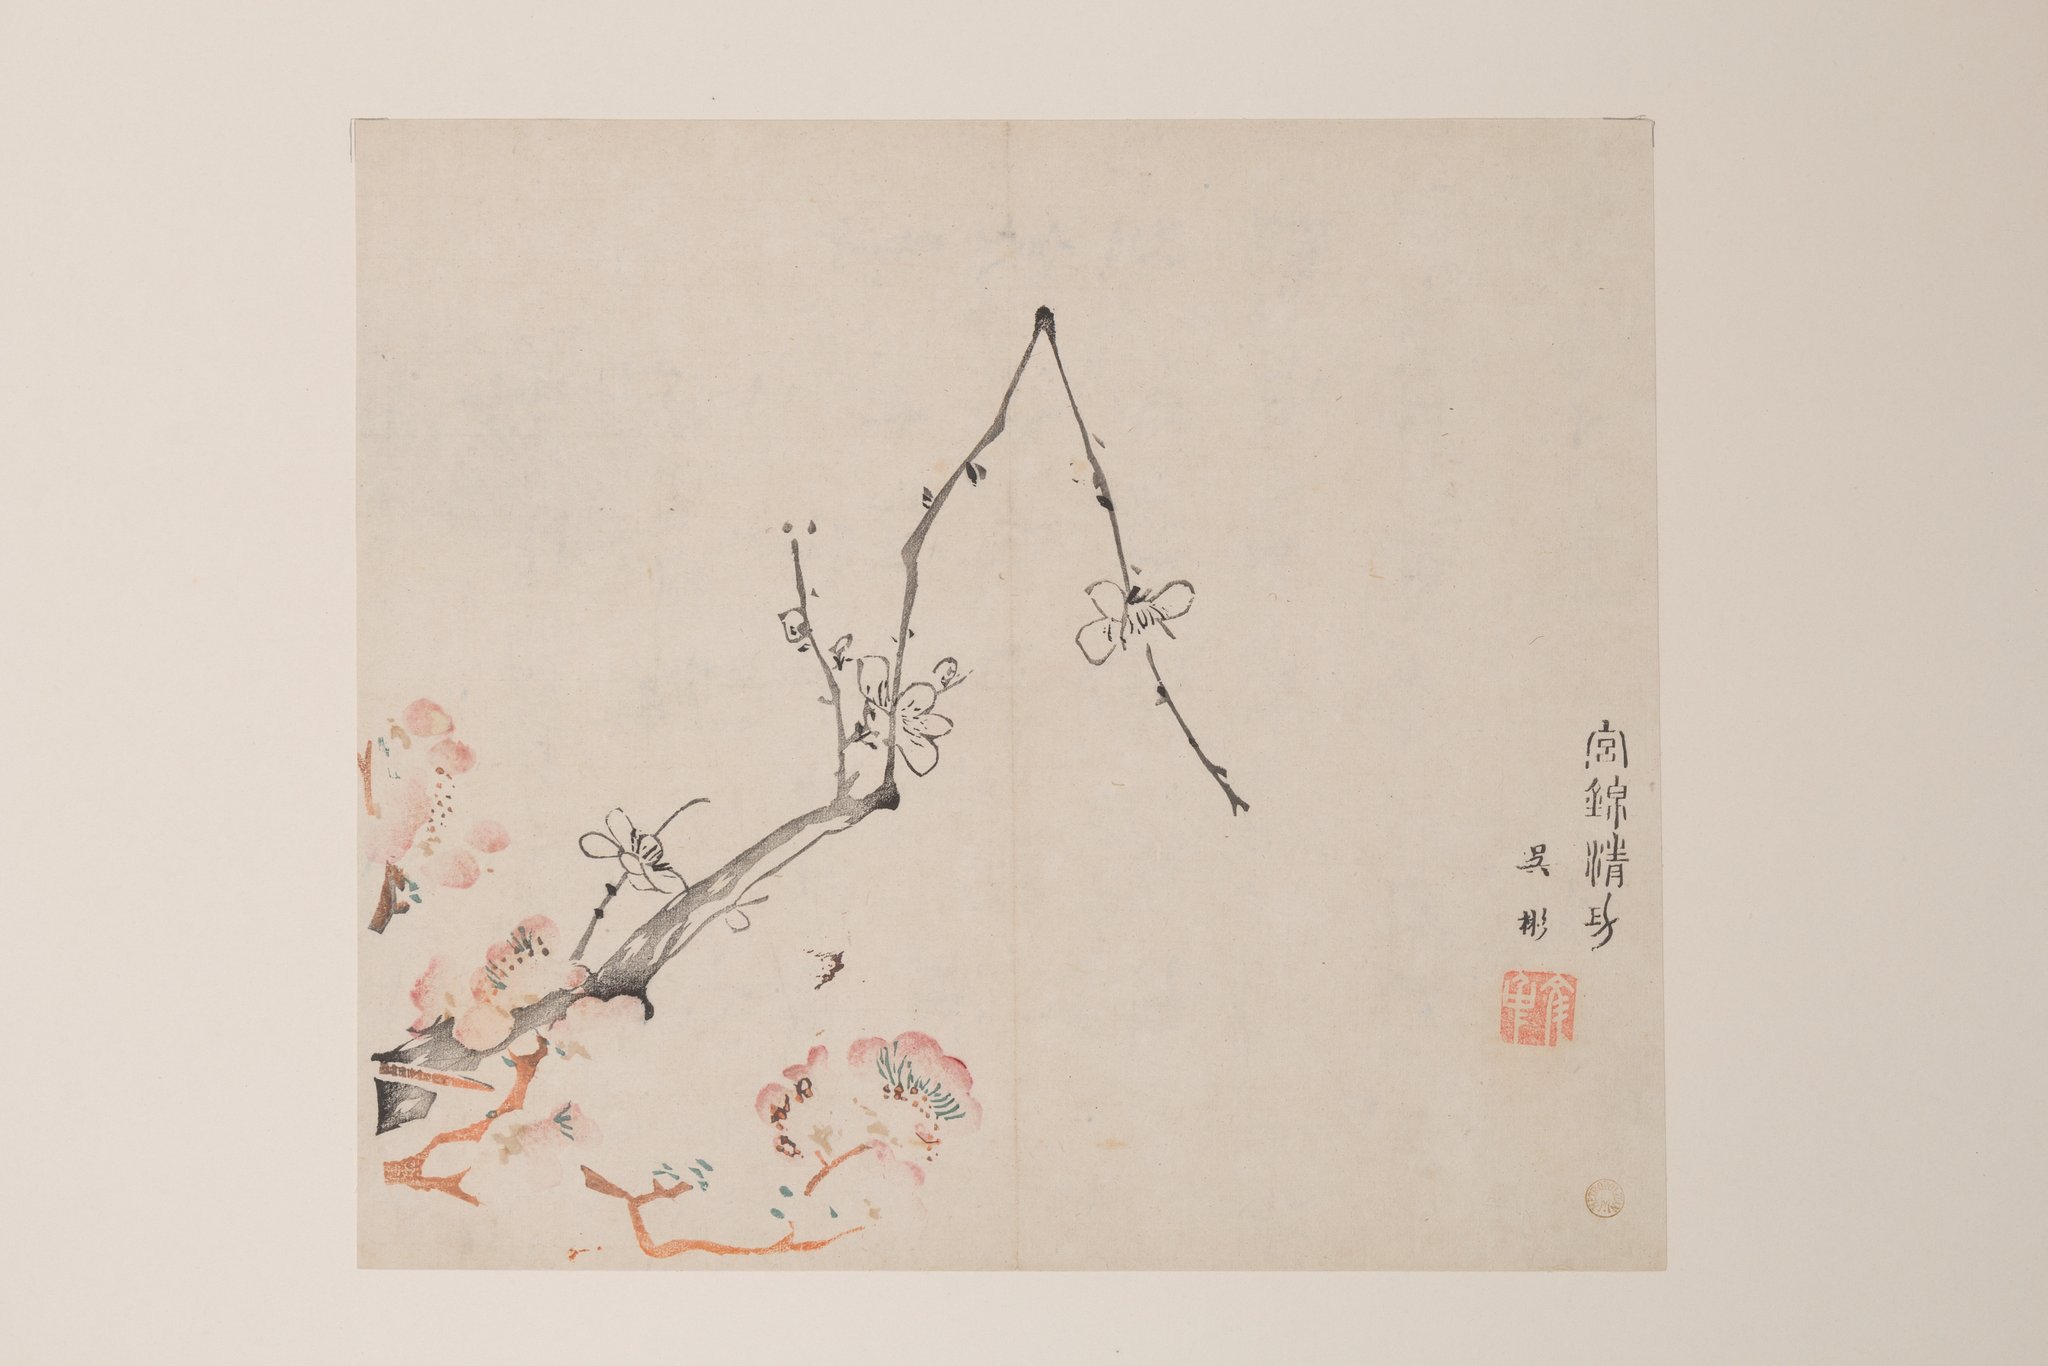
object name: print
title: Page from Shi Zhu Zhai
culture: chinese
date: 1662-1722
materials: ink, paper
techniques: polychrome, woodblock print